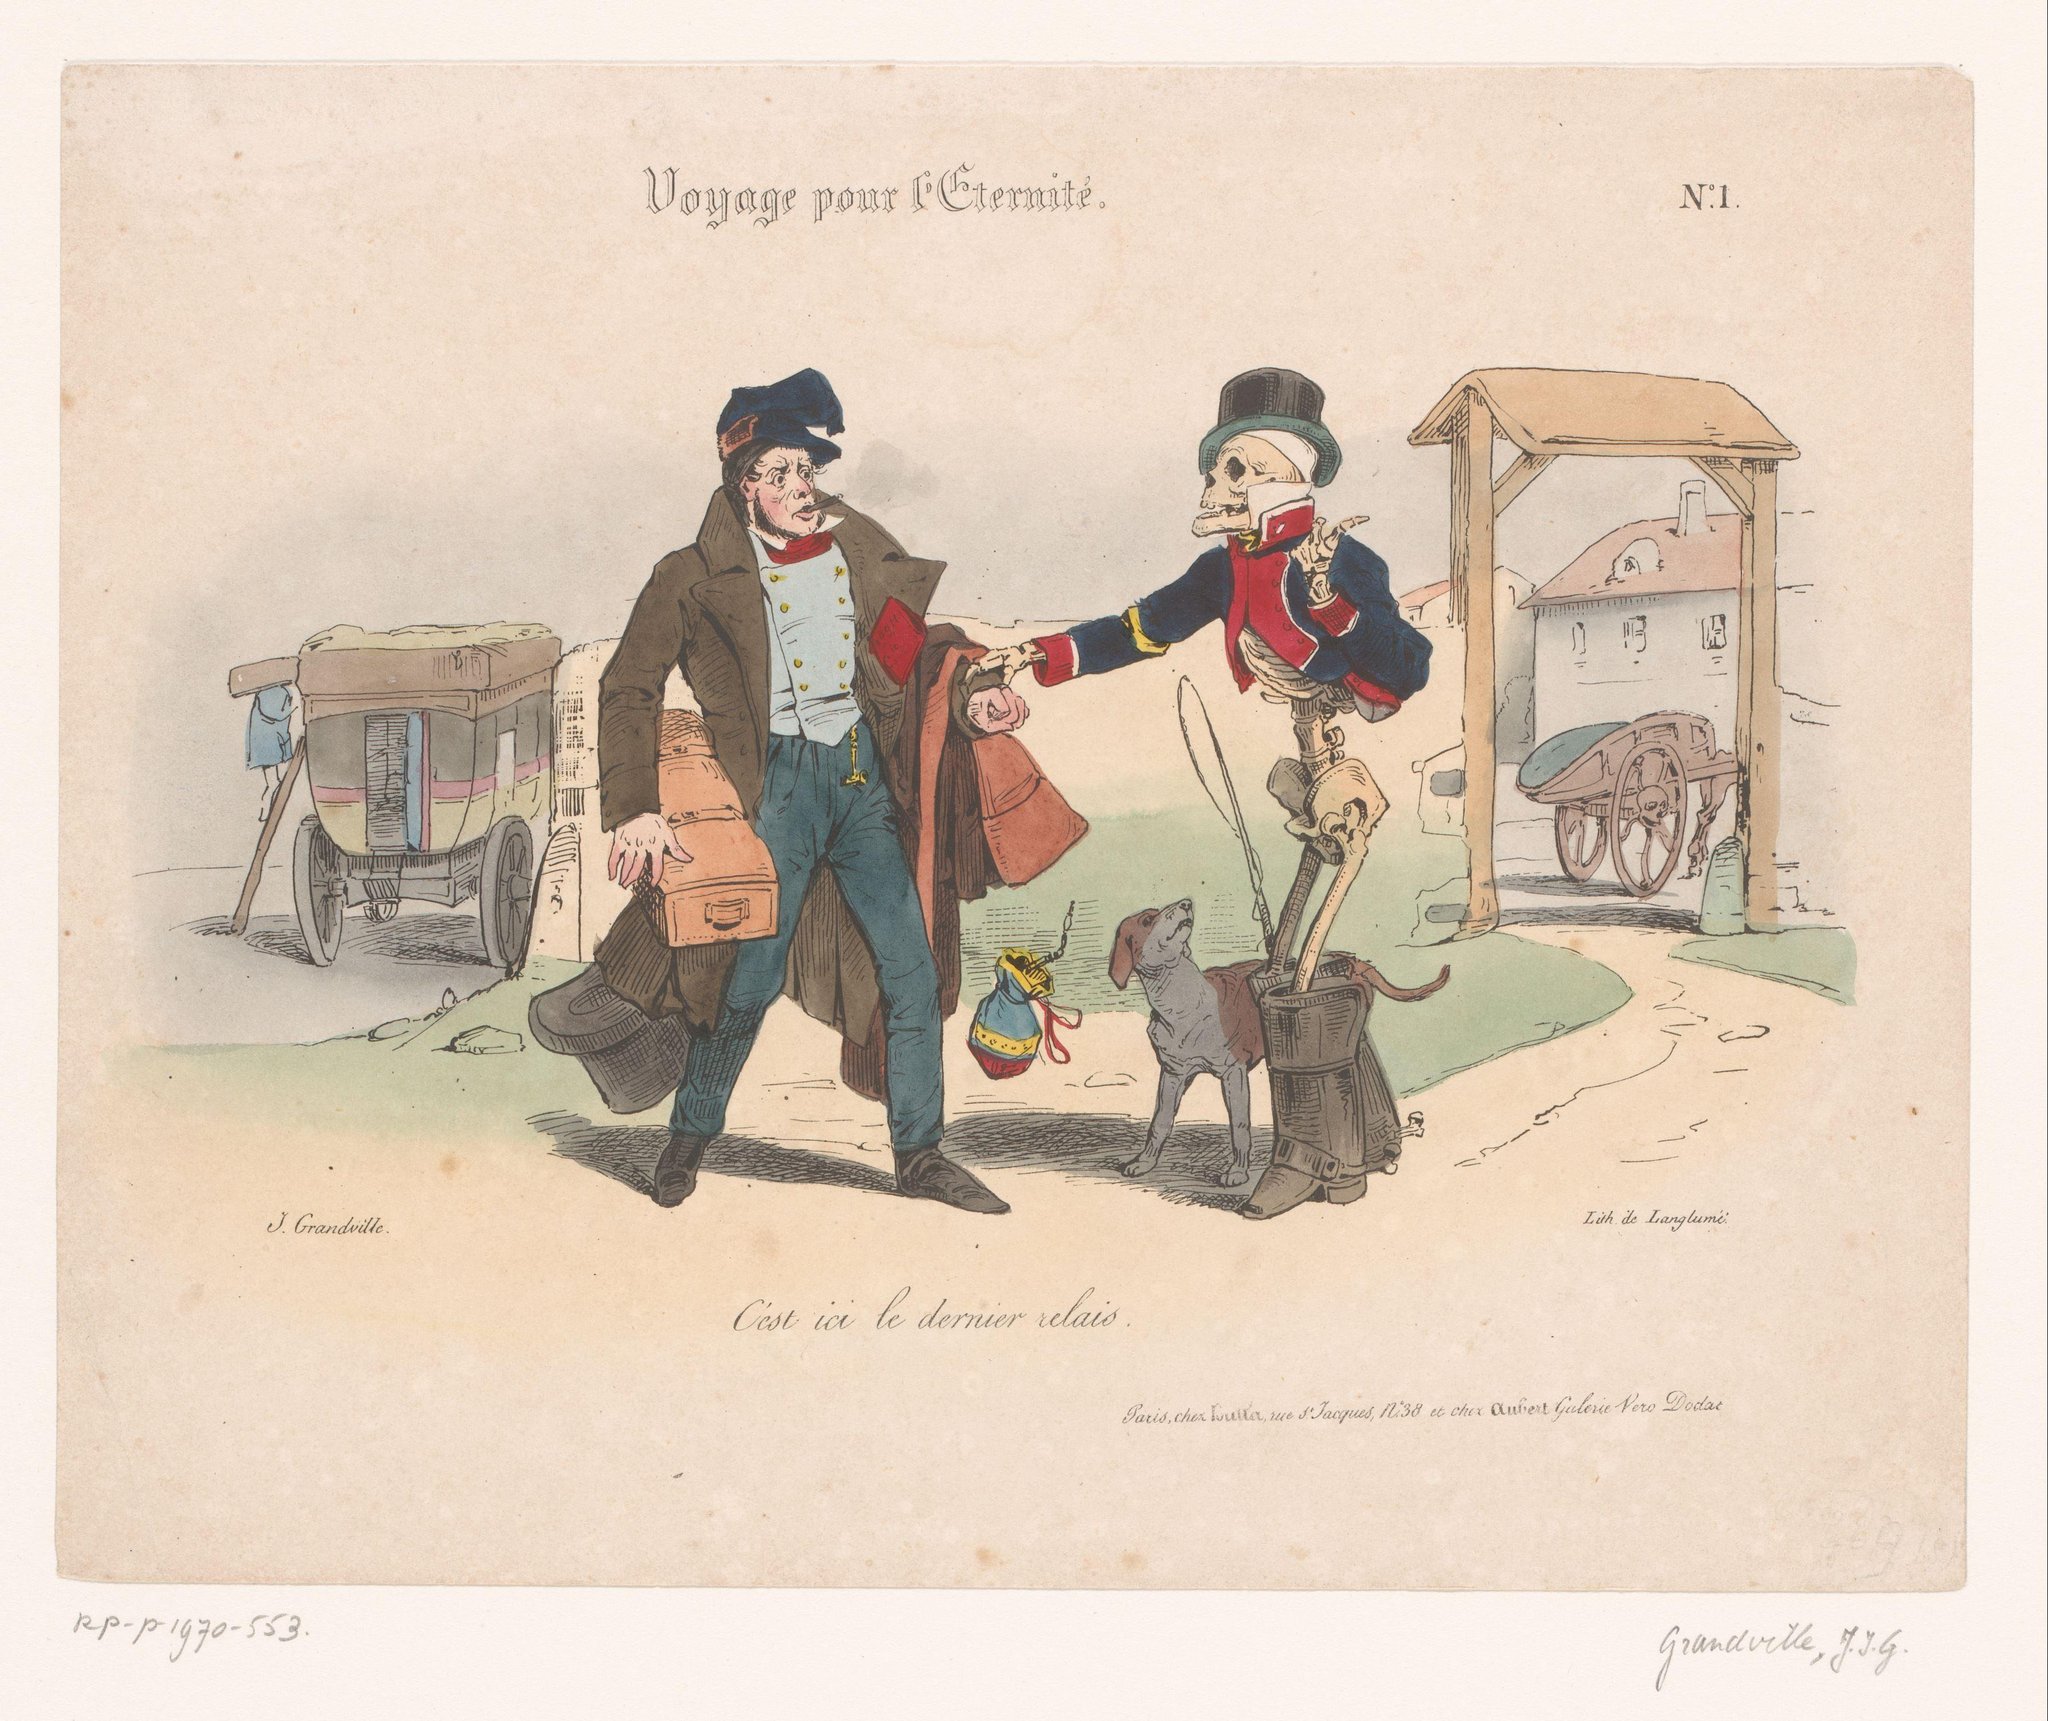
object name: cartoon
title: Voyage pour l'Eternité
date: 1830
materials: paper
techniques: hand coloring, lithograph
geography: paris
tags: animal traction, animal-drawn vehicle (carriage etc.), 'sudden death', death as skeleton, postman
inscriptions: collector's mark: Lugt 2228a